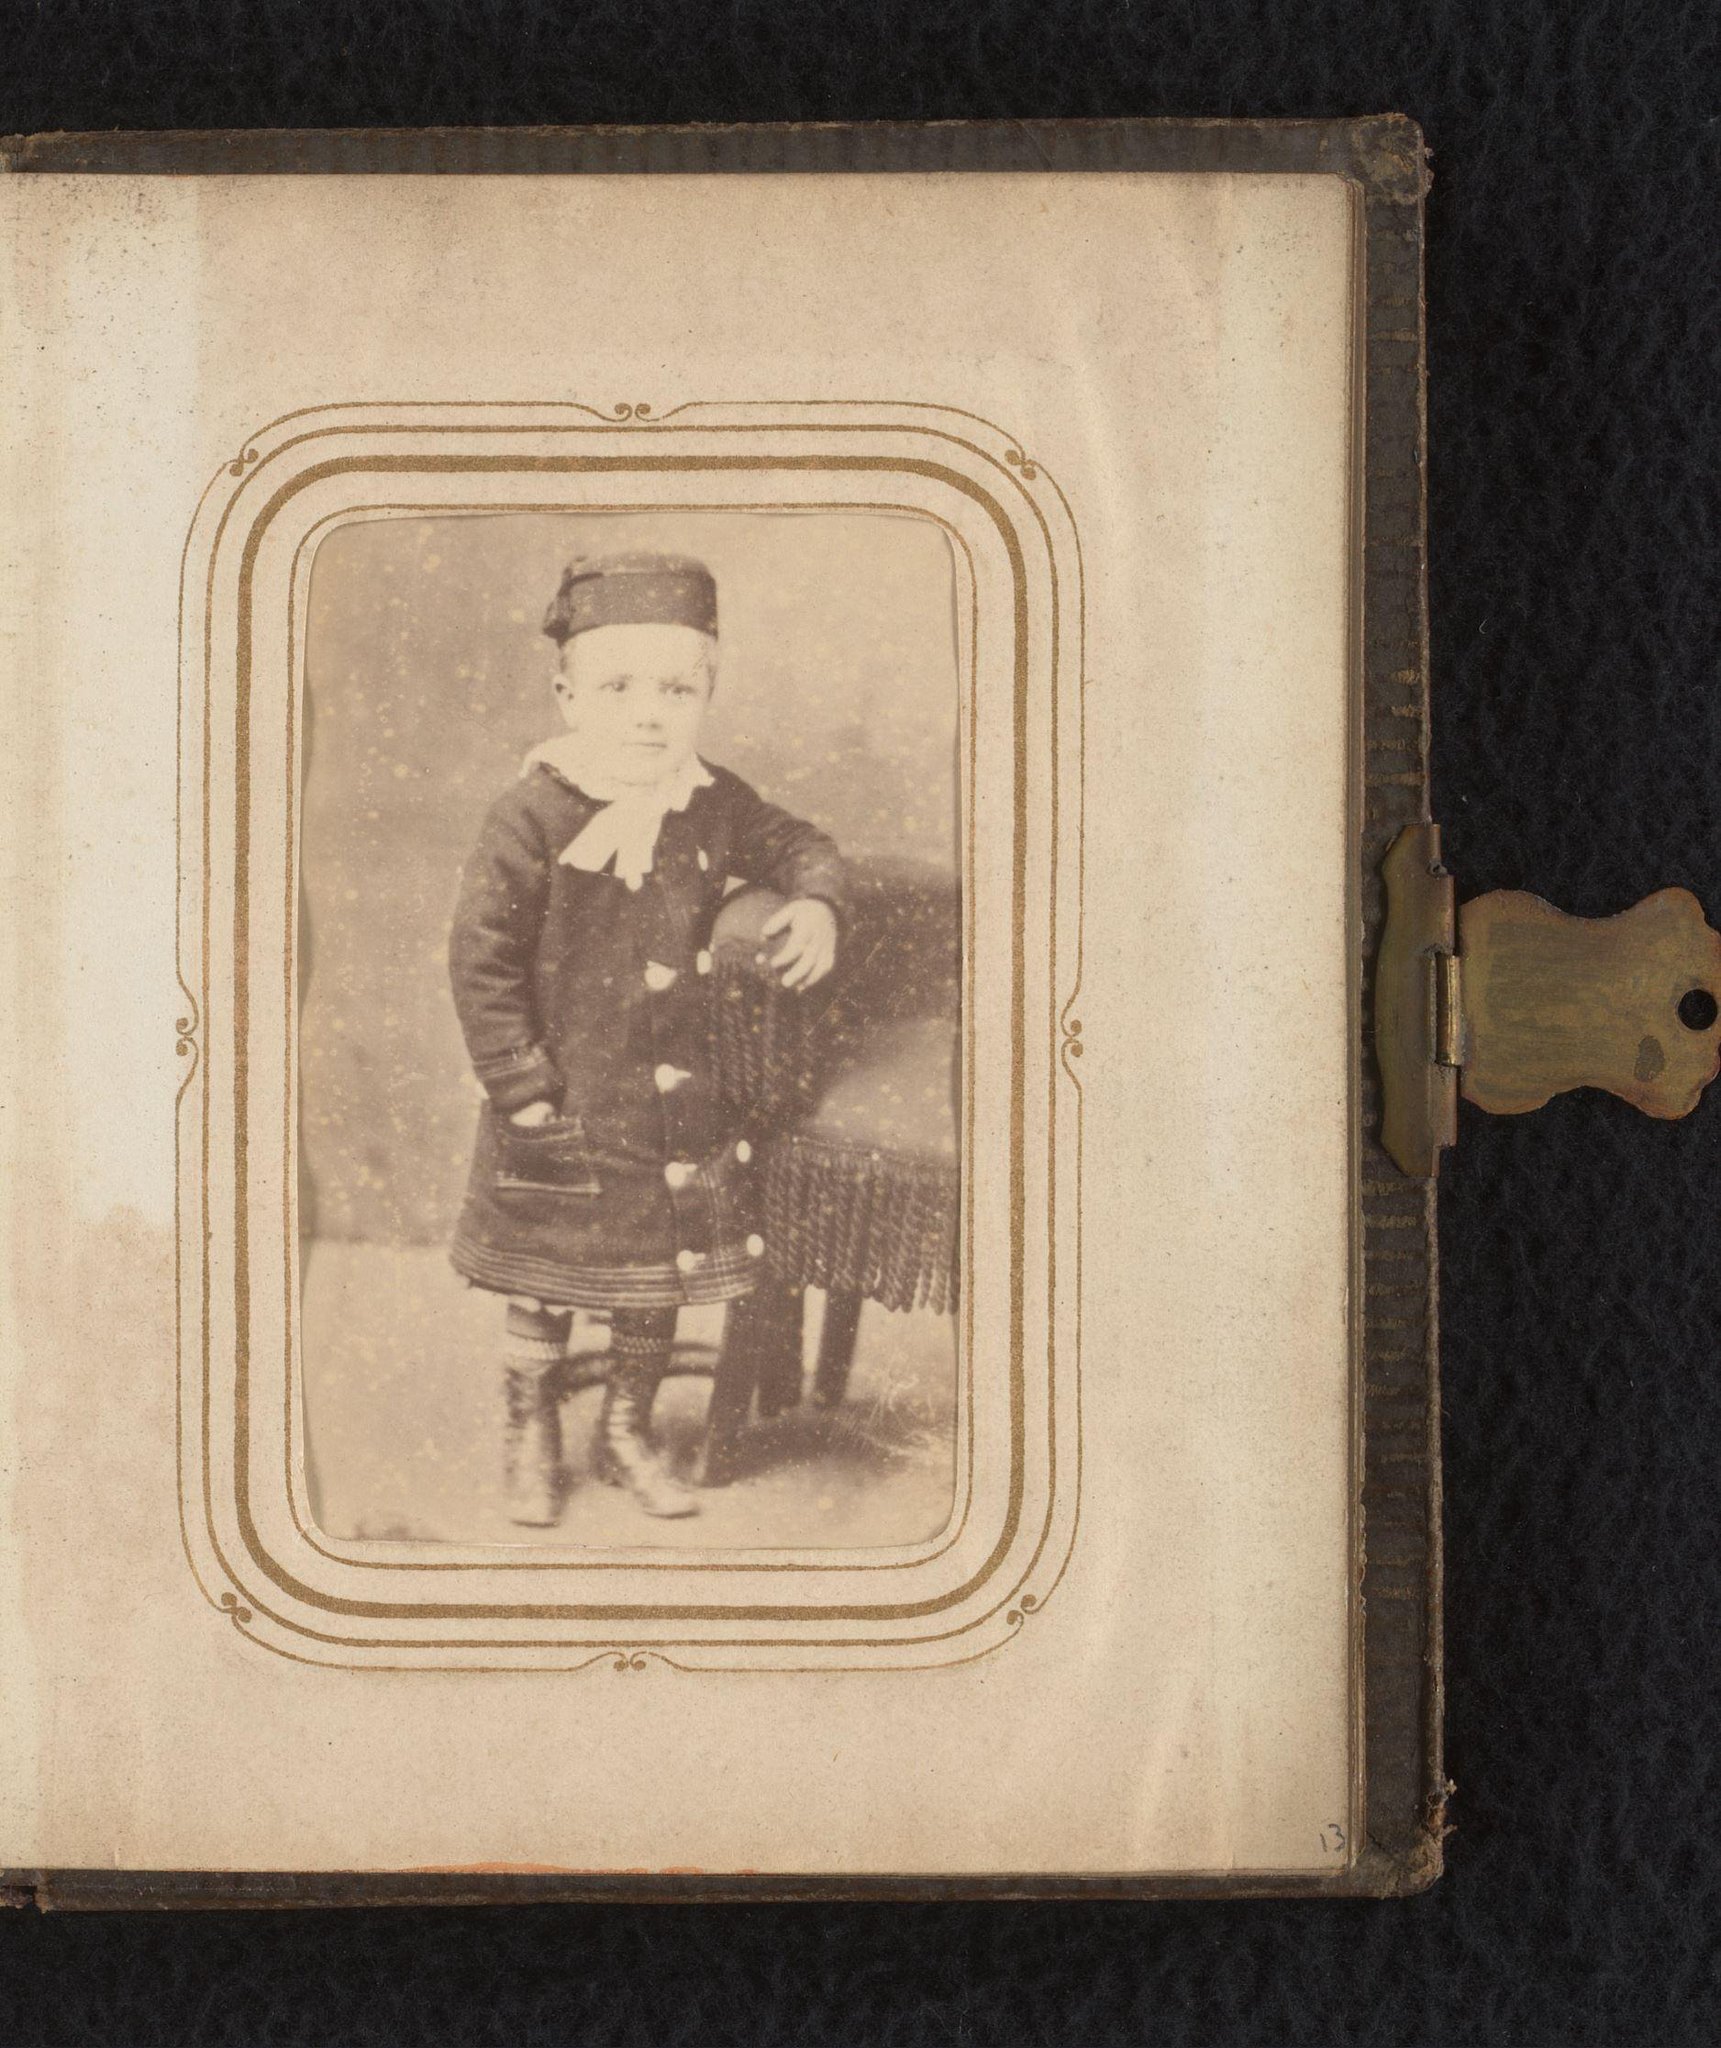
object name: carte de visite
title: Portret van een staand kind met muts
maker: Anonymous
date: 1860-1900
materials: cardboard, photographic support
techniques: albumen print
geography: san josé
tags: child, head-gear: cap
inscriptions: inscription: ‘Wright 284 Santa Clara St., San Jose, Cal.’